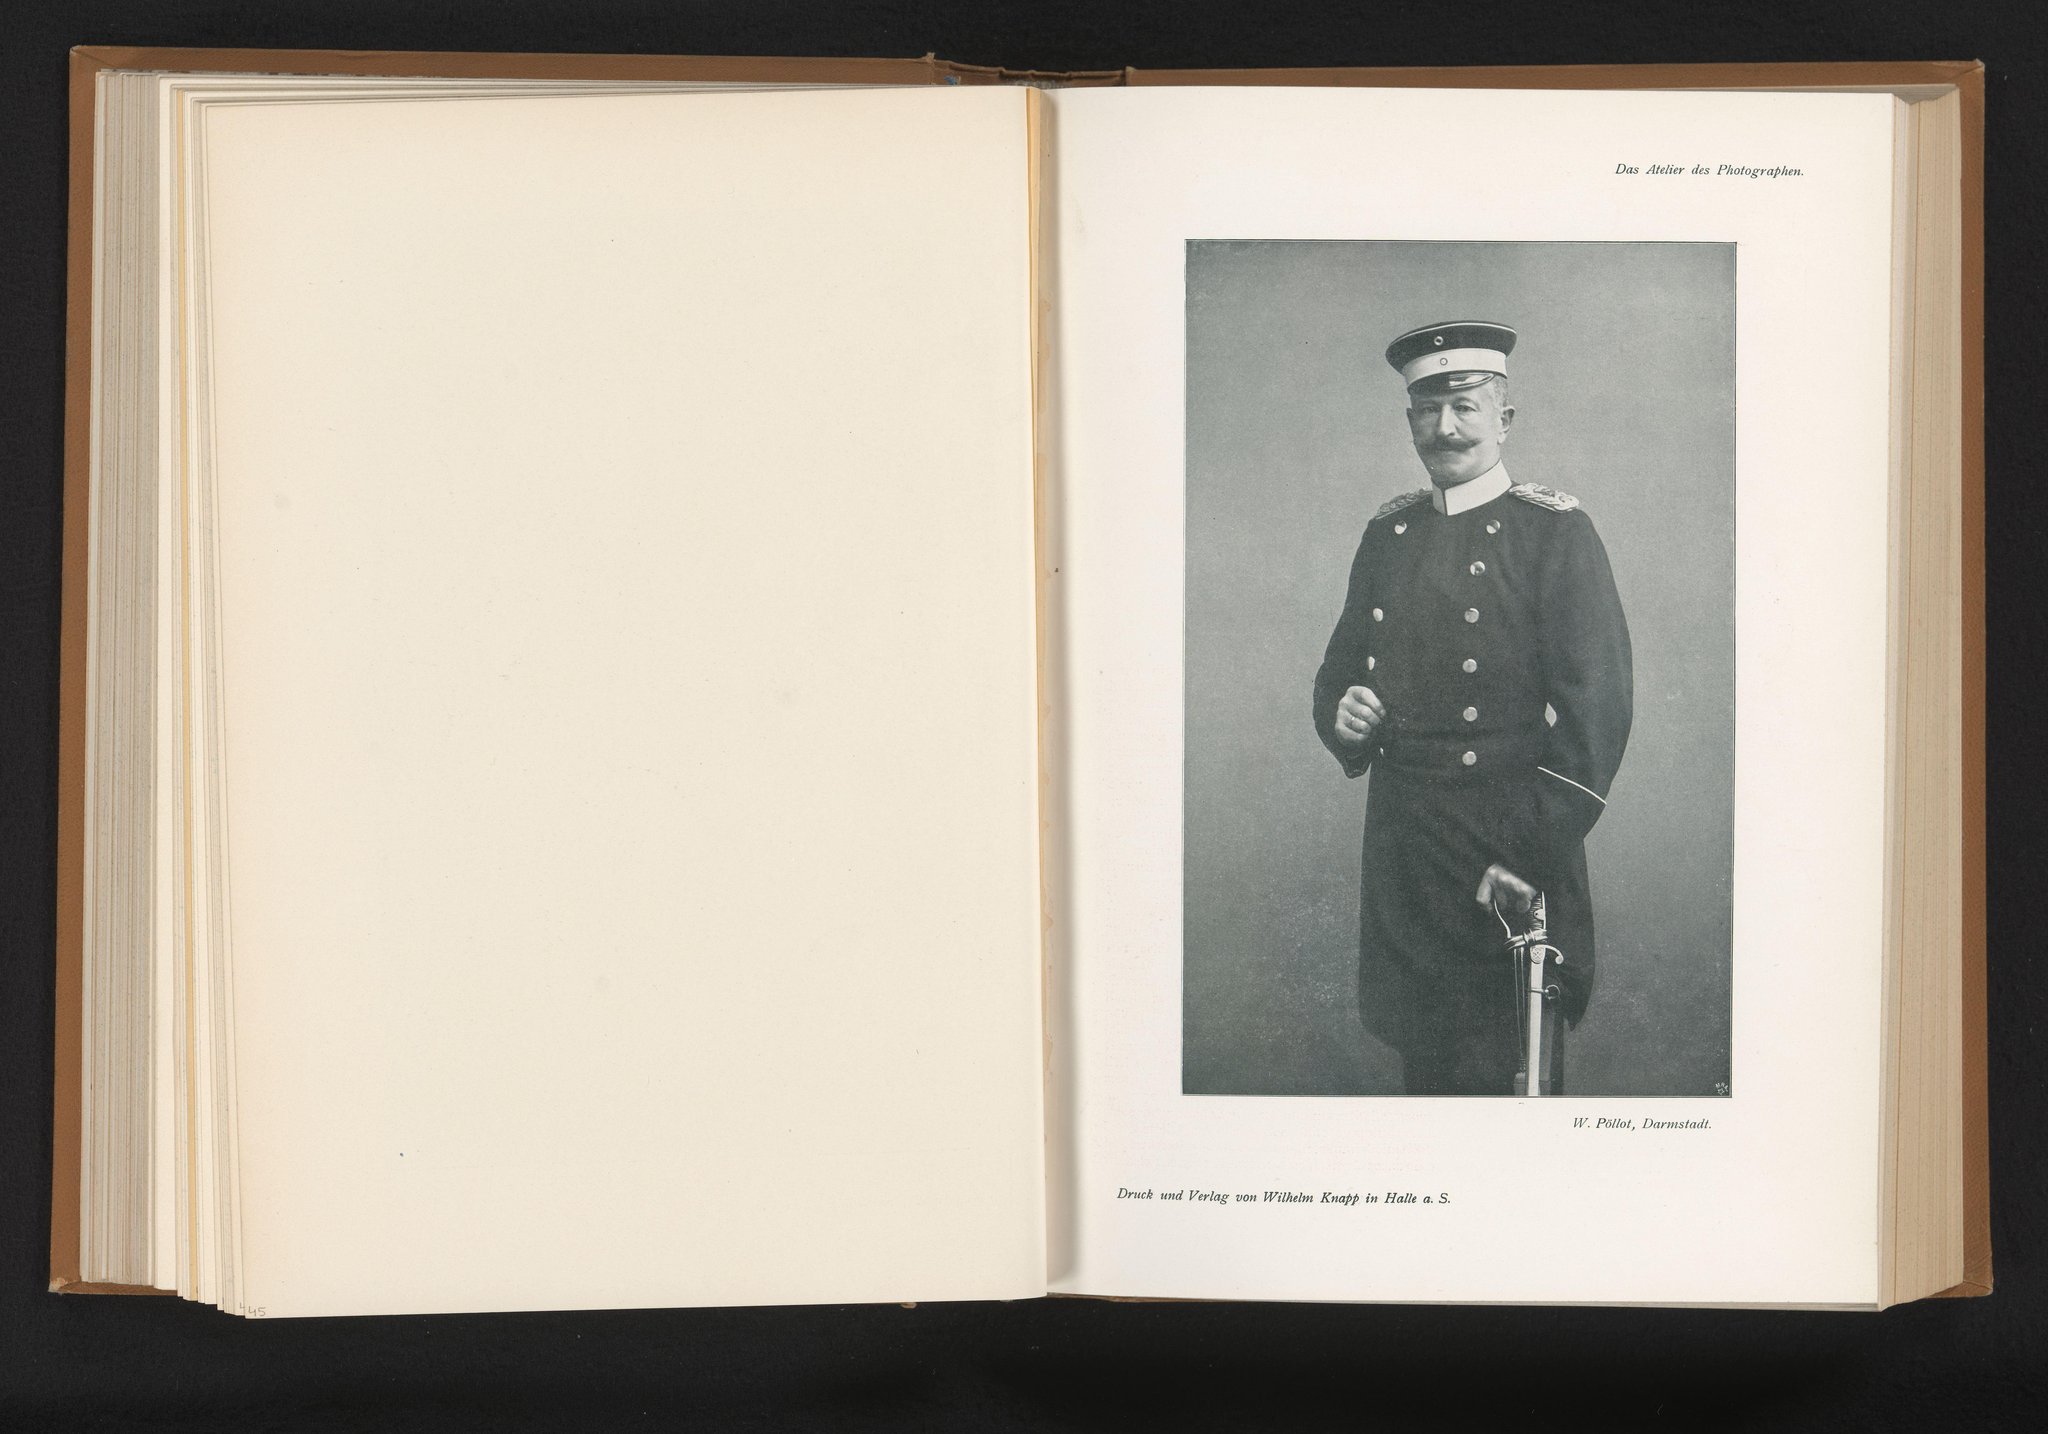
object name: photomechanical print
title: Portret van een onbekende man in uniform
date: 1895-1900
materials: paper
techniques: autotype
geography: halle an der saale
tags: historical persons, (military) uniforms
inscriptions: inscription: ‘Das Atelier des Photographen.’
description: Prent op vijfde ongenummerde pagina na pagina 176.